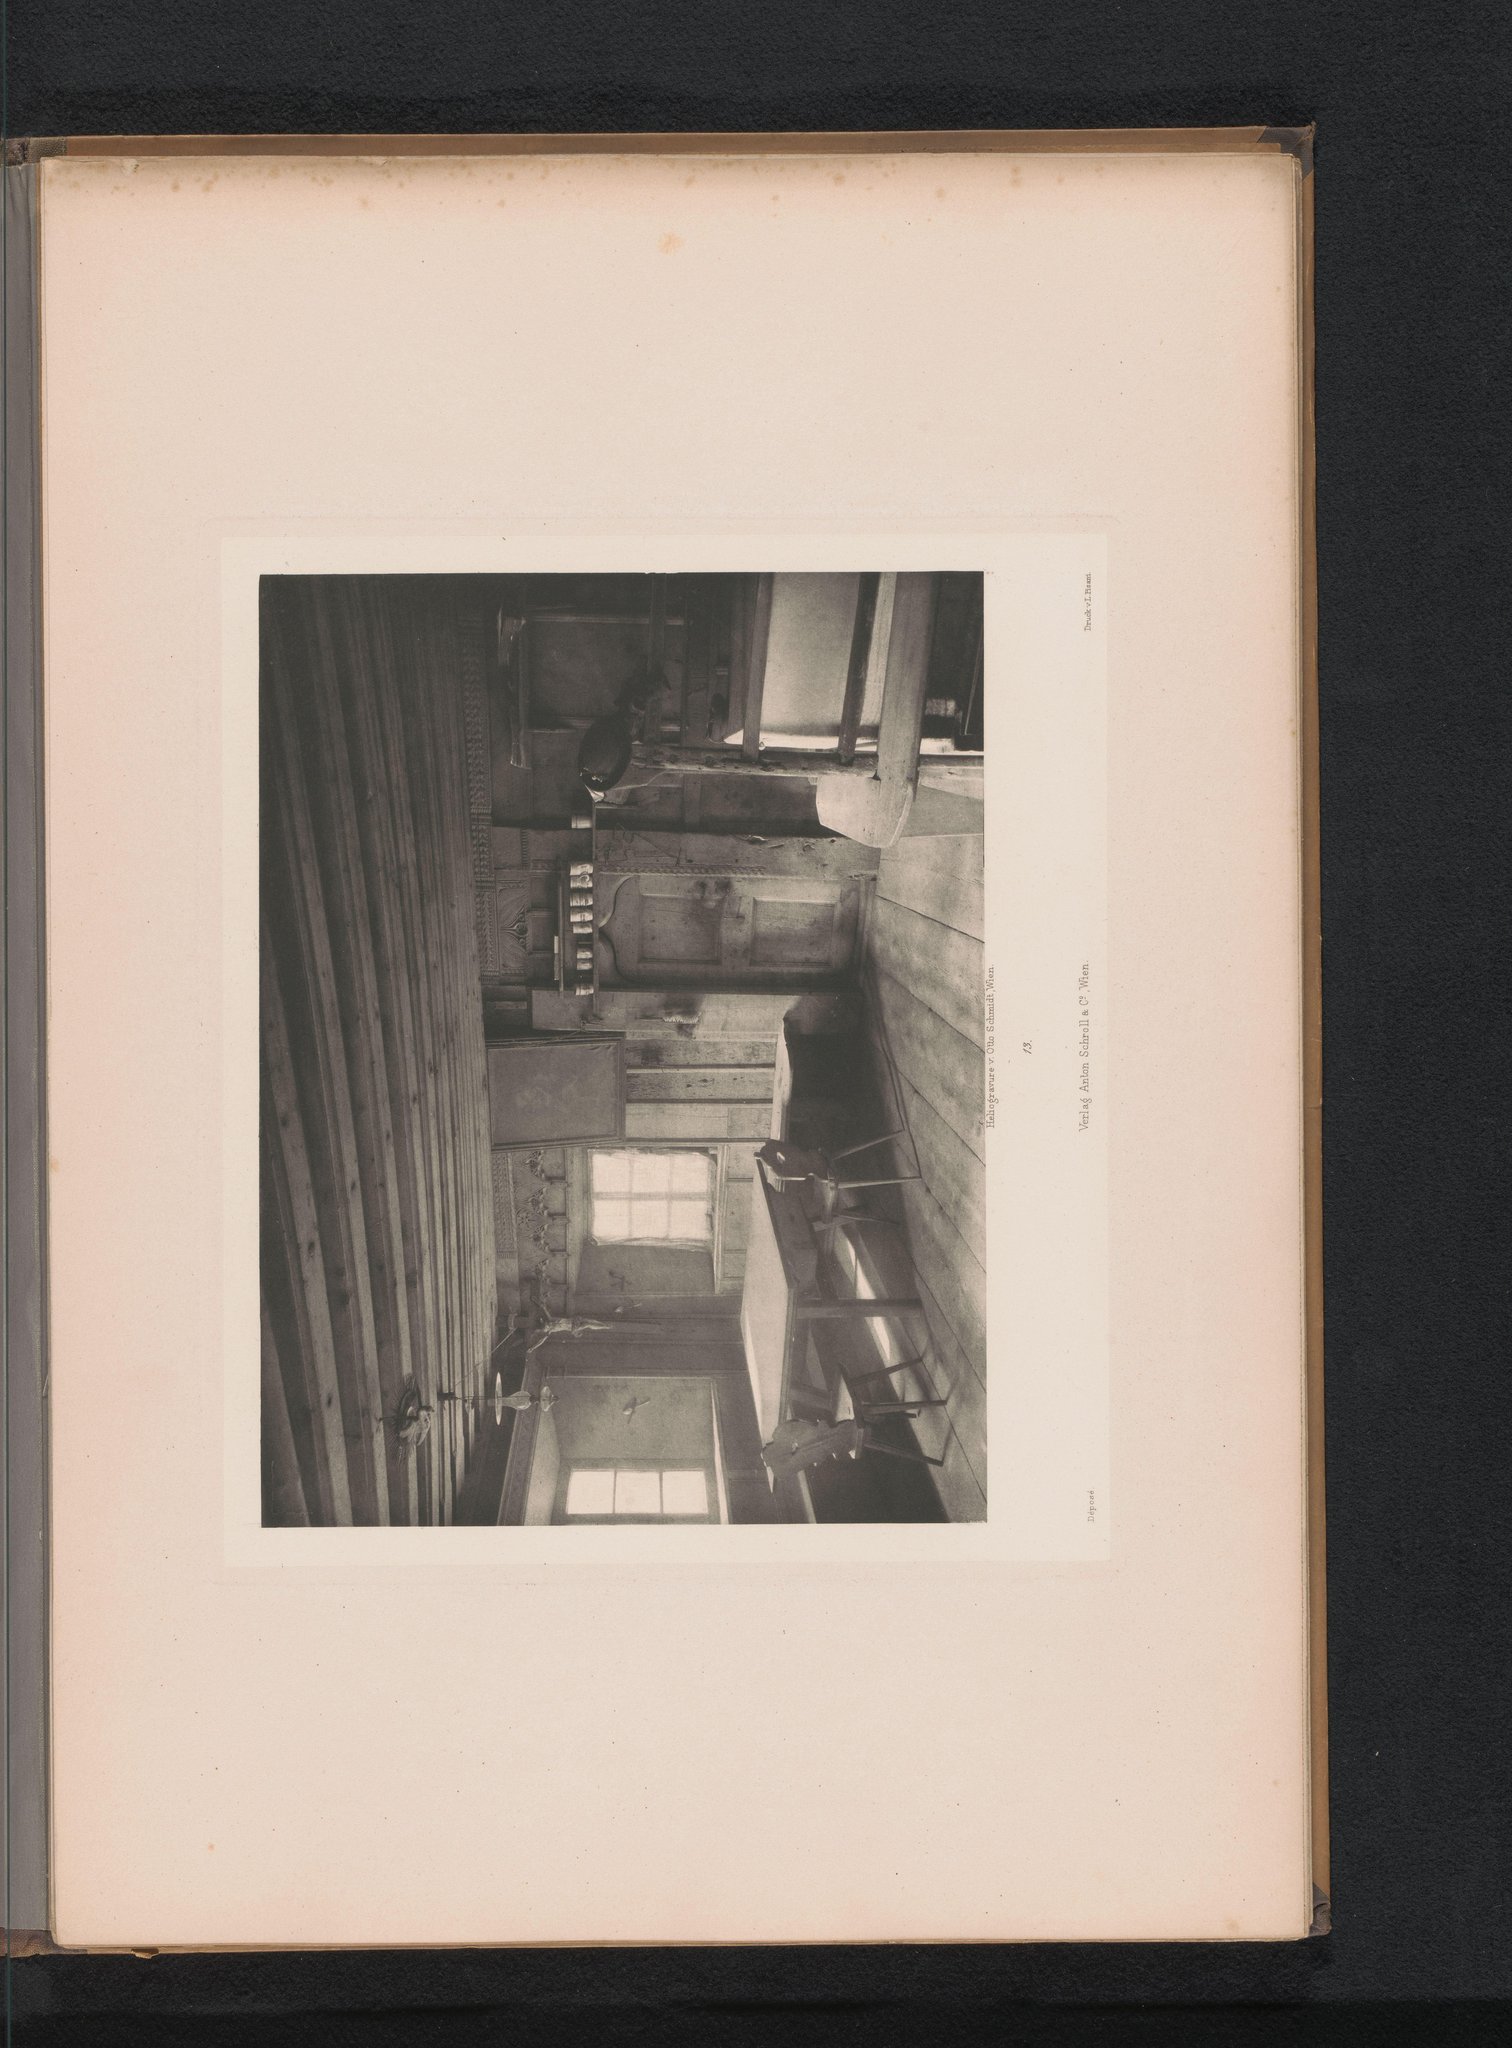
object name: photomechanical print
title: Gezicht op een kamer in een woning in Klausen, Italië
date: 1886-1891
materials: paper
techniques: photoaquatint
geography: vienna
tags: other rooms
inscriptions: number: ‘13.’, inscription: ‘Déposé.’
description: Deze prent maakt deel uit van een omslag met dertig prenten en drie tekstbladen.